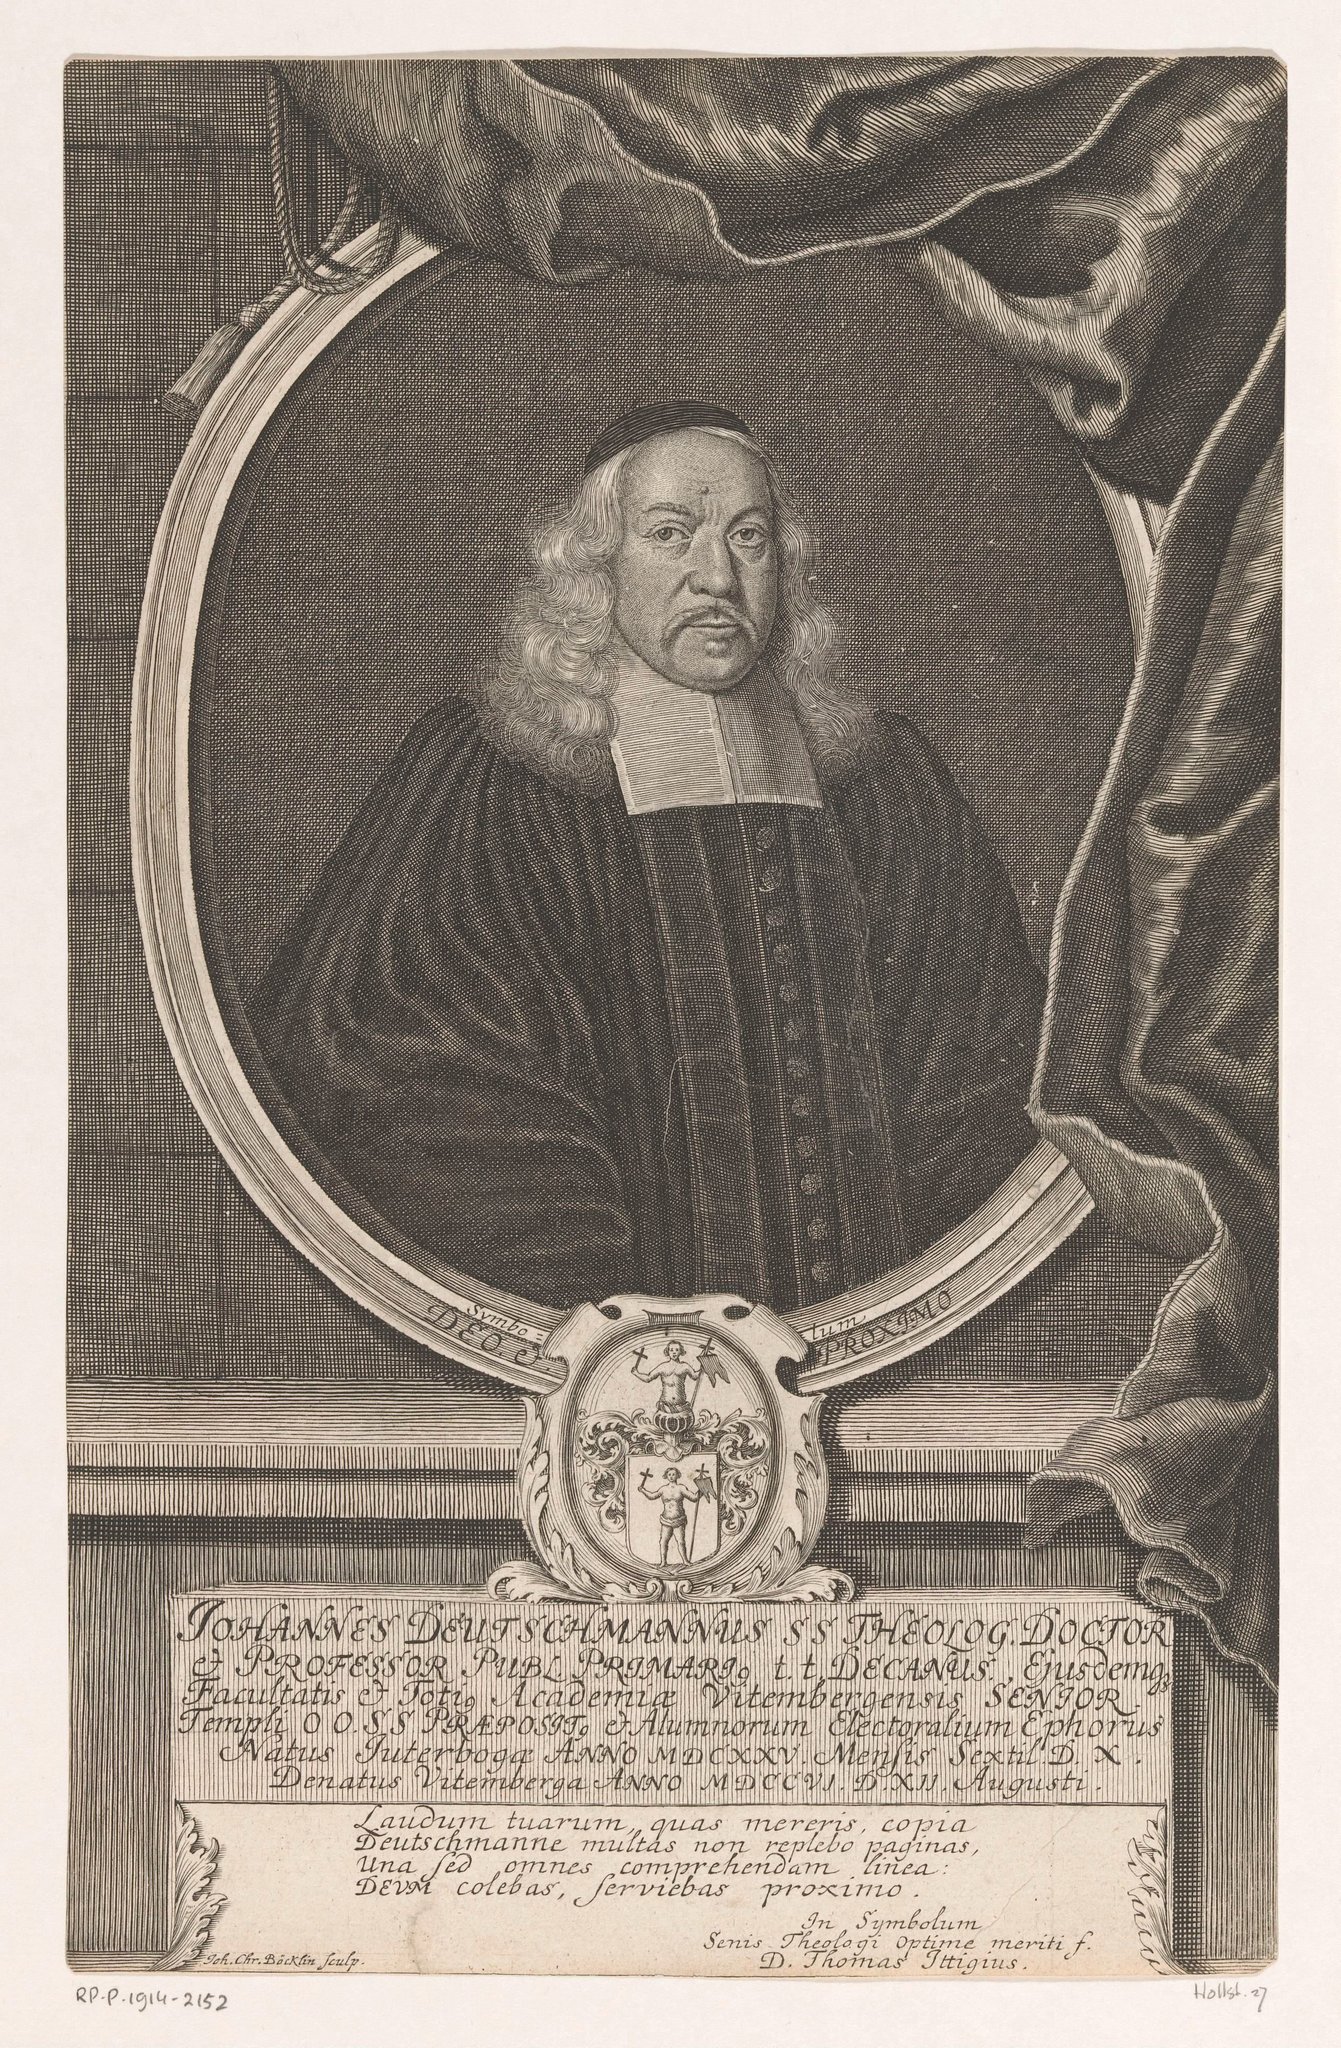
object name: print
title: Portret van Johann Deutschmann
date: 1706-1709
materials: paper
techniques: engraving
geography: leipzig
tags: johann deutschmann, historical persons, armorial bearing, heraldry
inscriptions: collector's mark: Lugt 2228